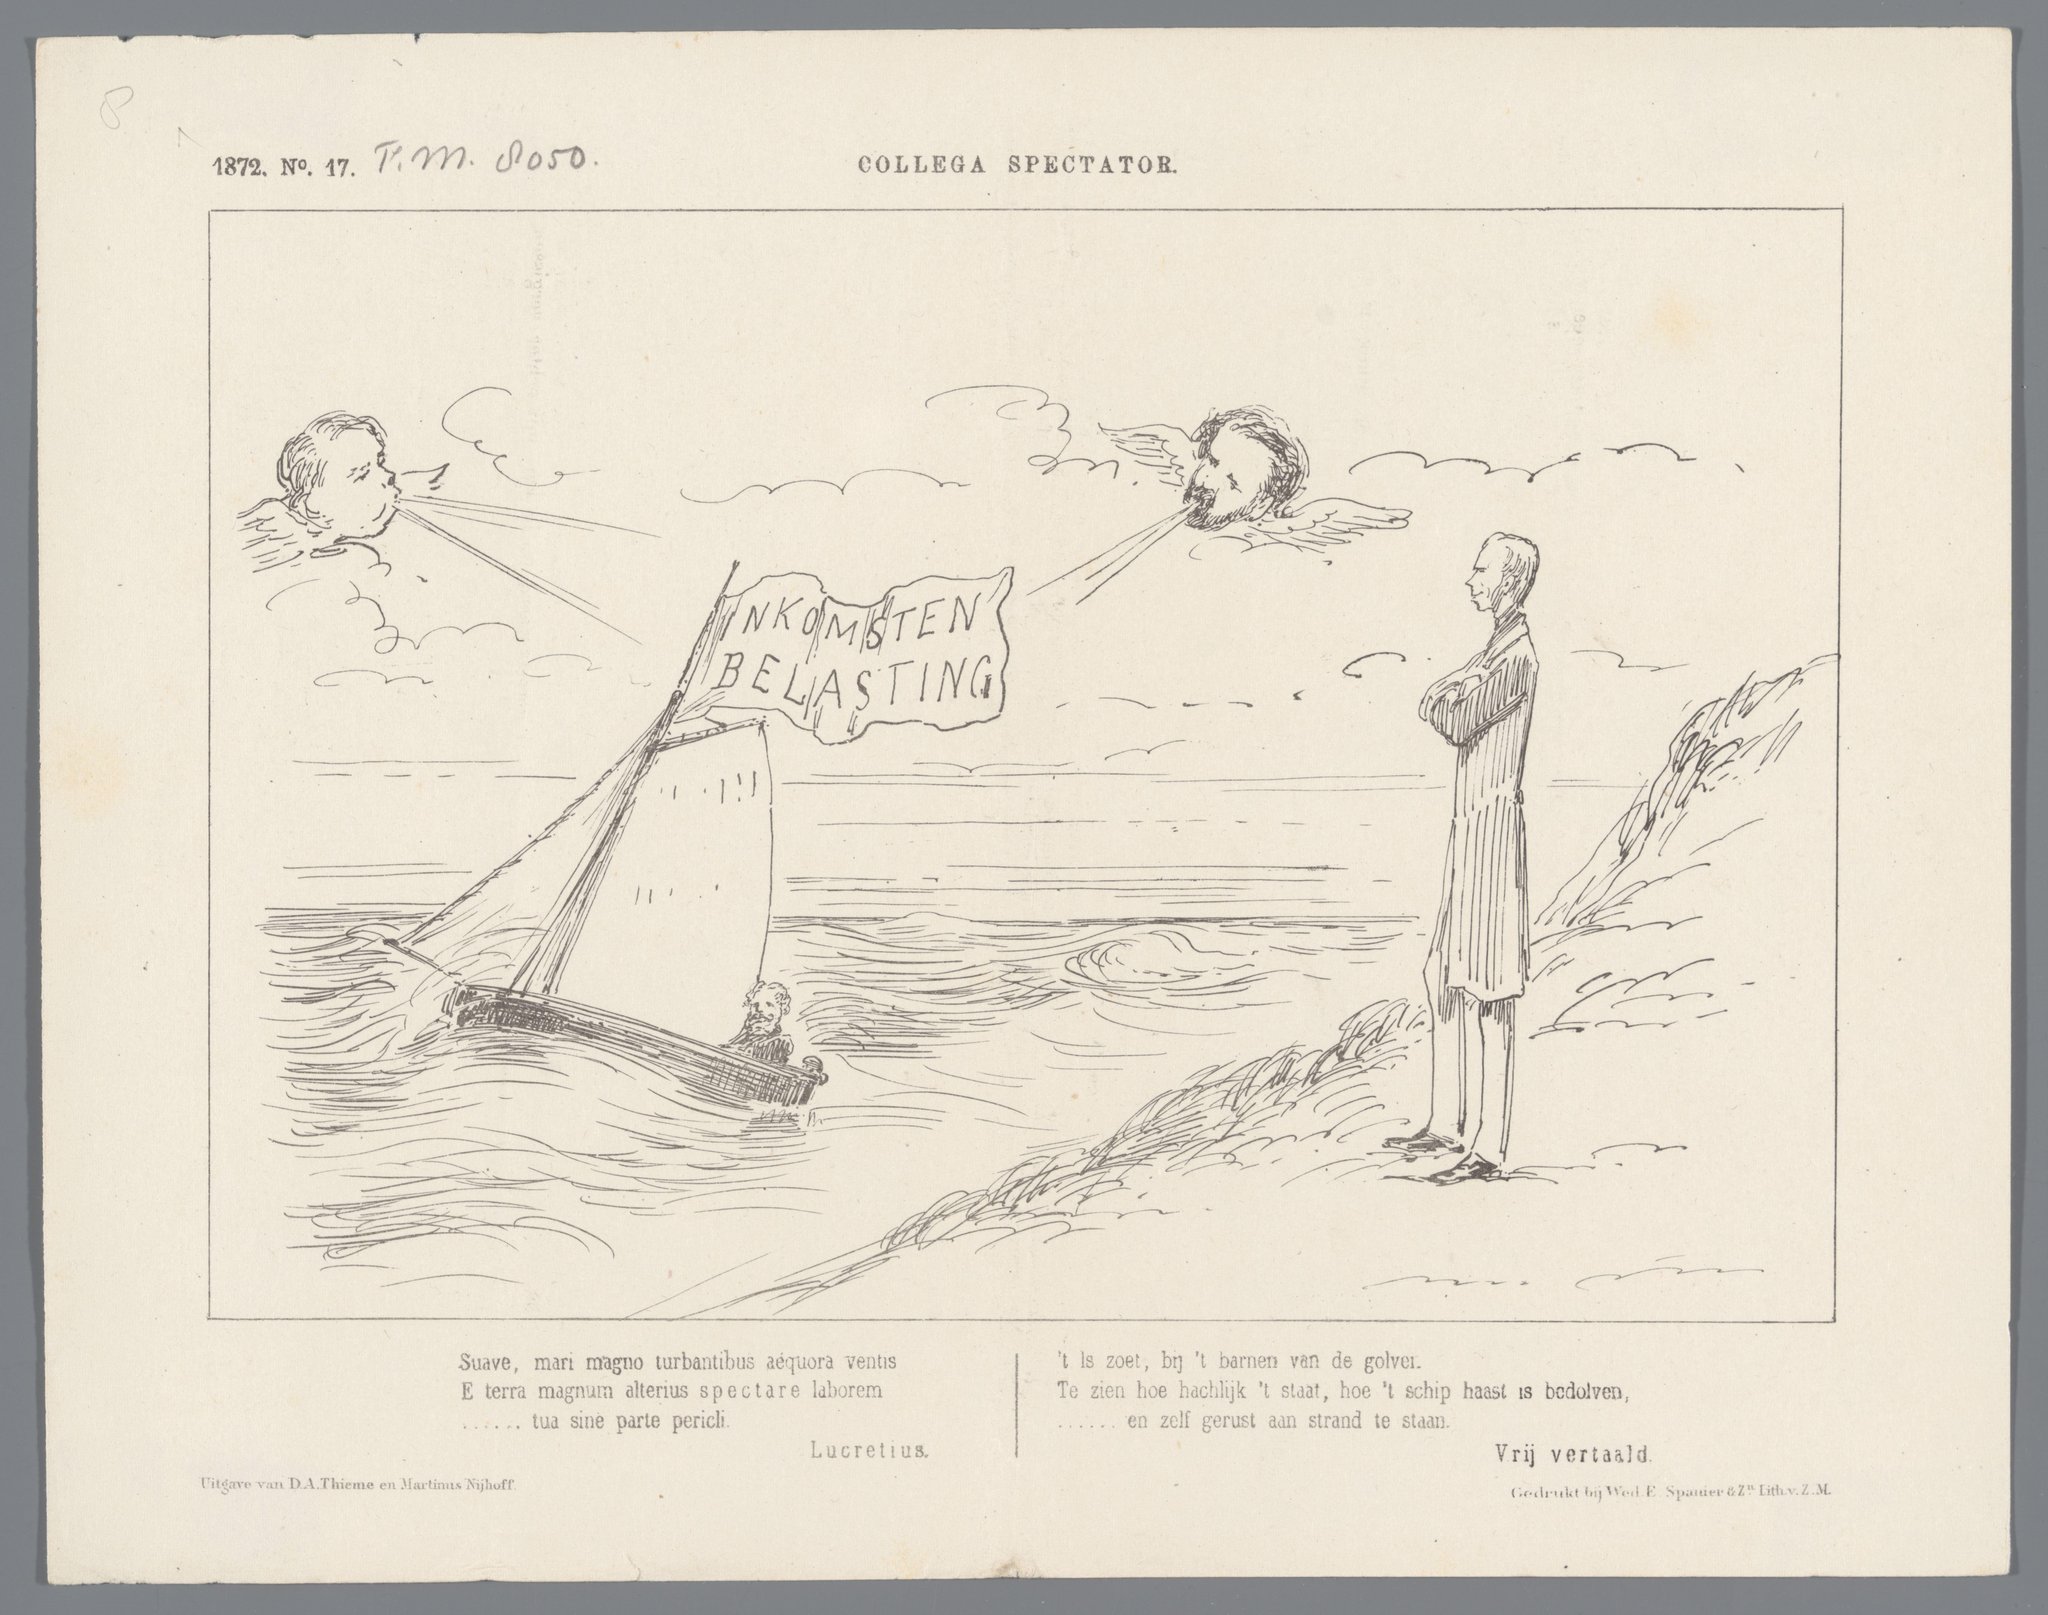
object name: cartoon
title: Spotprent op het wetsontwerp over de inkomstenbelasting, 1872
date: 1872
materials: paper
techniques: lithograph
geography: arnhem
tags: the hague, johan rudolf thorbecke, pieter blussé van oud-alblas, sailing-ship, sailing-boat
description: Spotprent op de behandeling van het wetsontwerp van Blussé over de inkomstenbelasting in de Tweede Kamer, waarbij Thorbecke afwezig was. Thorbecke wandelend over het strand ziet hoe het zeilbootje 'inkomstenbelasting' door de wind heen en weer beblazen wordt. Plaat verschenen bij het weekblad De Nederlandsche Spectator, nr. 17, 1872.